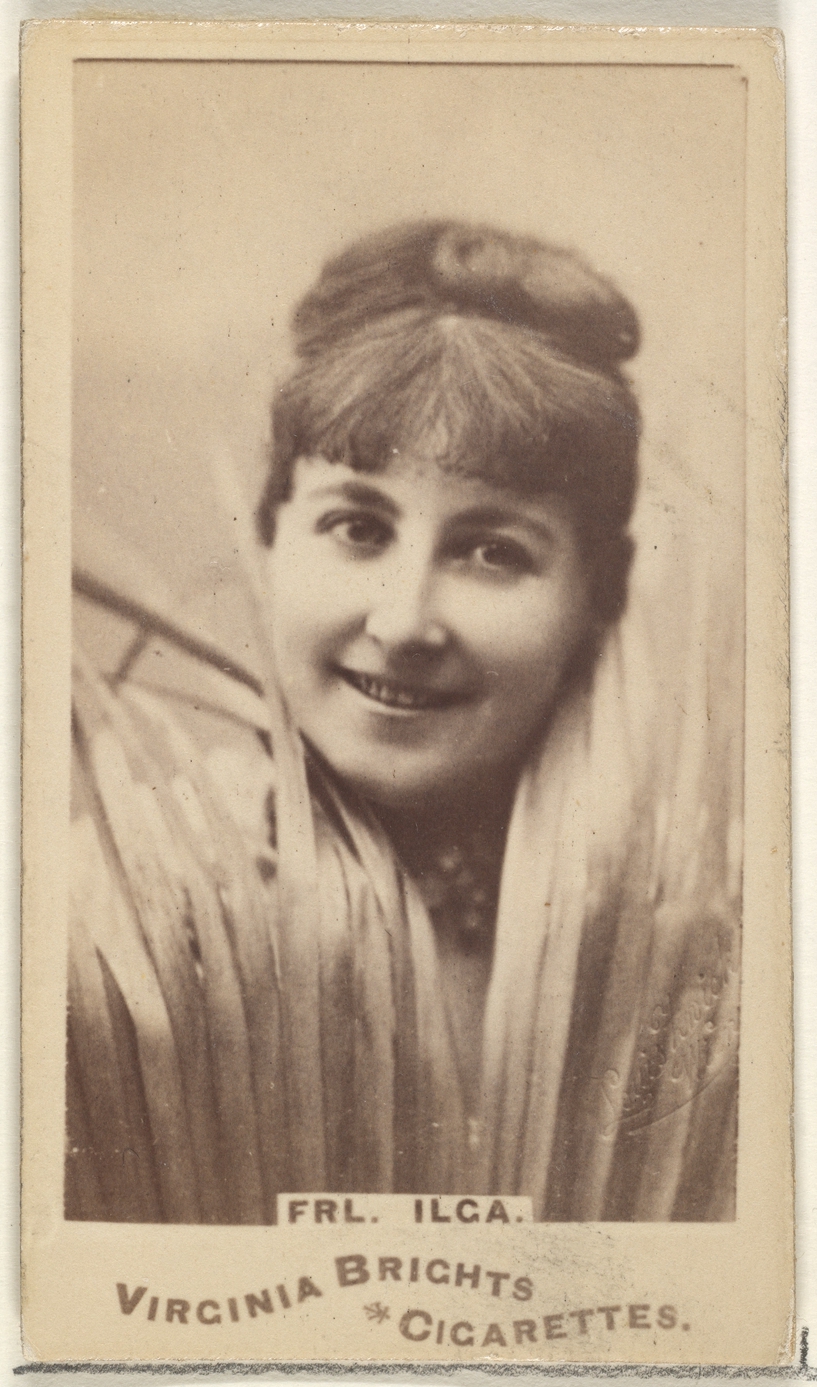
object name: photograph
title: Fräulein Ilga, from the Actors and Actresses series (N45, Type 1) for Virginia Brights Cigarettes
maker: allen & ginter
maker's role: publisher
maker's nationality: american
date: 1888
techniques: albumen silver print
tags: portraits,women,actresses